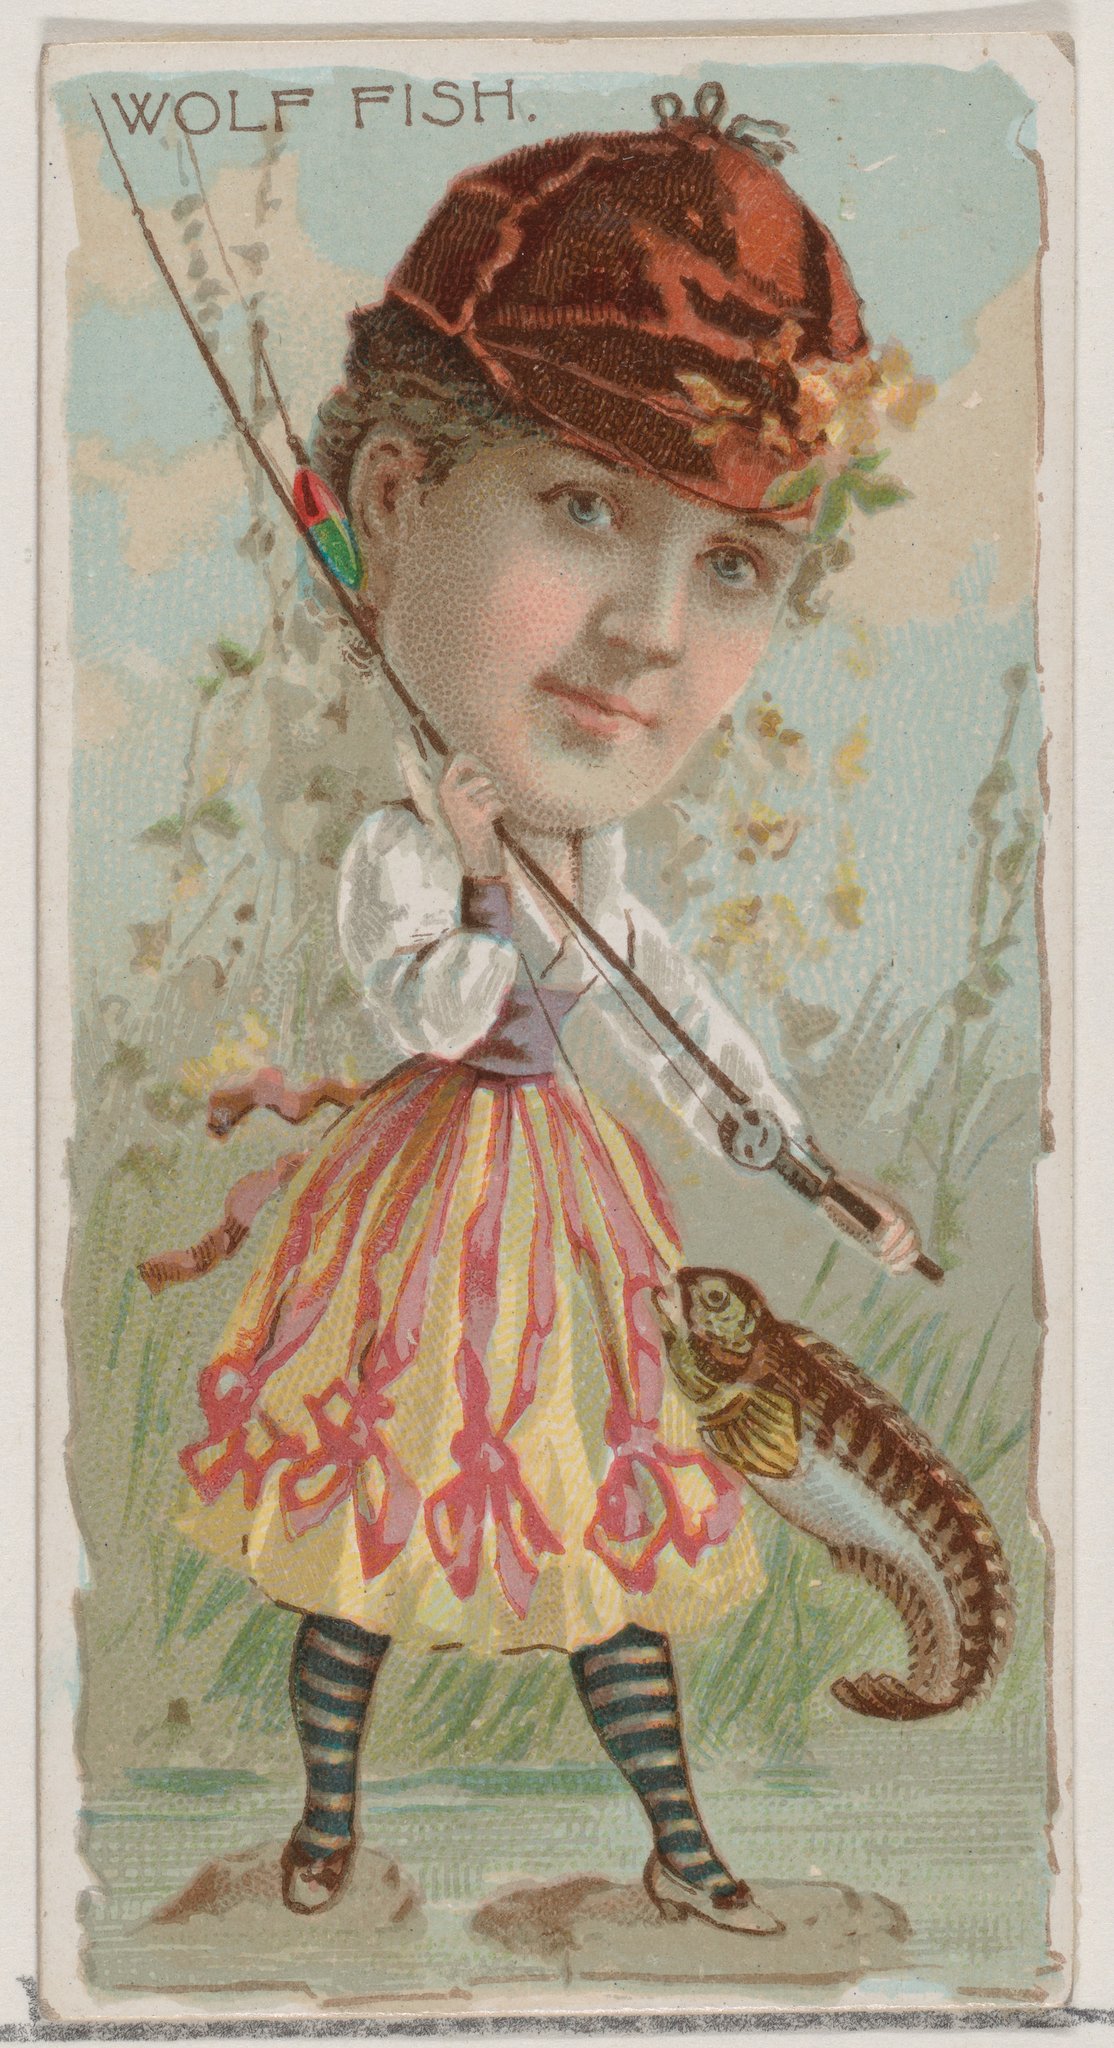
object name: print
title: Wolf Fish, from the series Fishers and Fish (N74) for Duke brand cigarettes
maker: knapp & company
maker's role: lithographer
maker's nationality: american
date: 1888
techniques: color lithograph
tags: women,fishing,fish